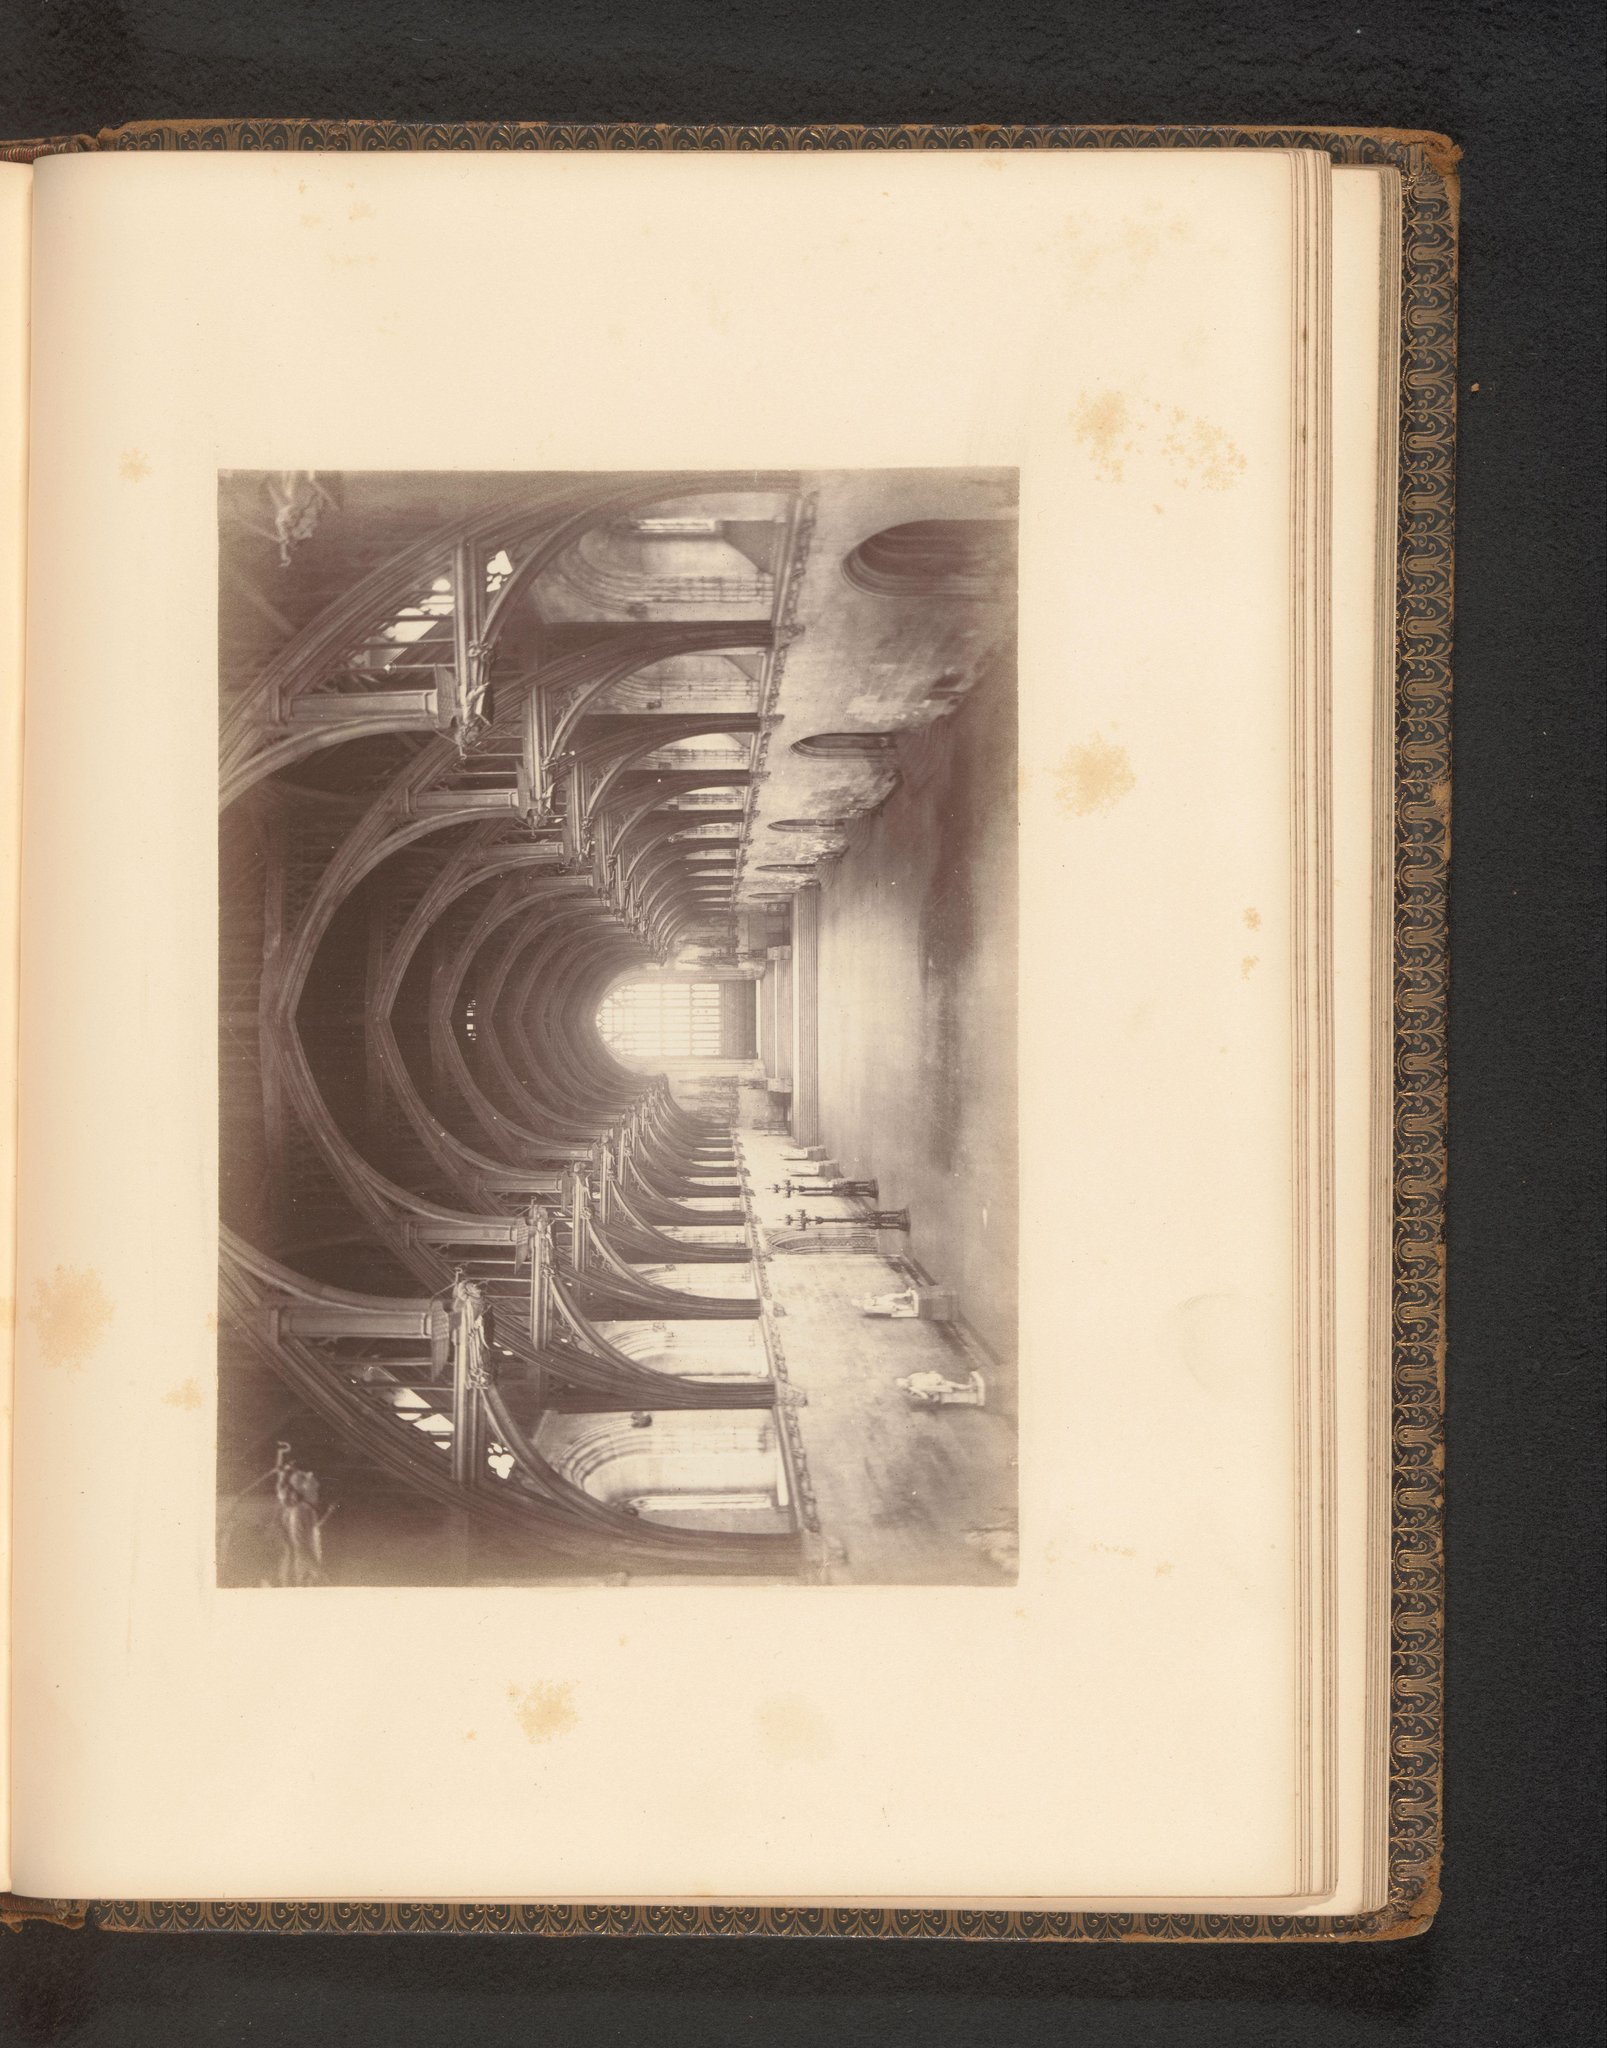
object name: photograph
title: Westminster Hall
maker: john harrington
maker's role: fotograaf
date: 1864-1869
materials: photographic support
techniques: albumen print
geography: london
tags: palace